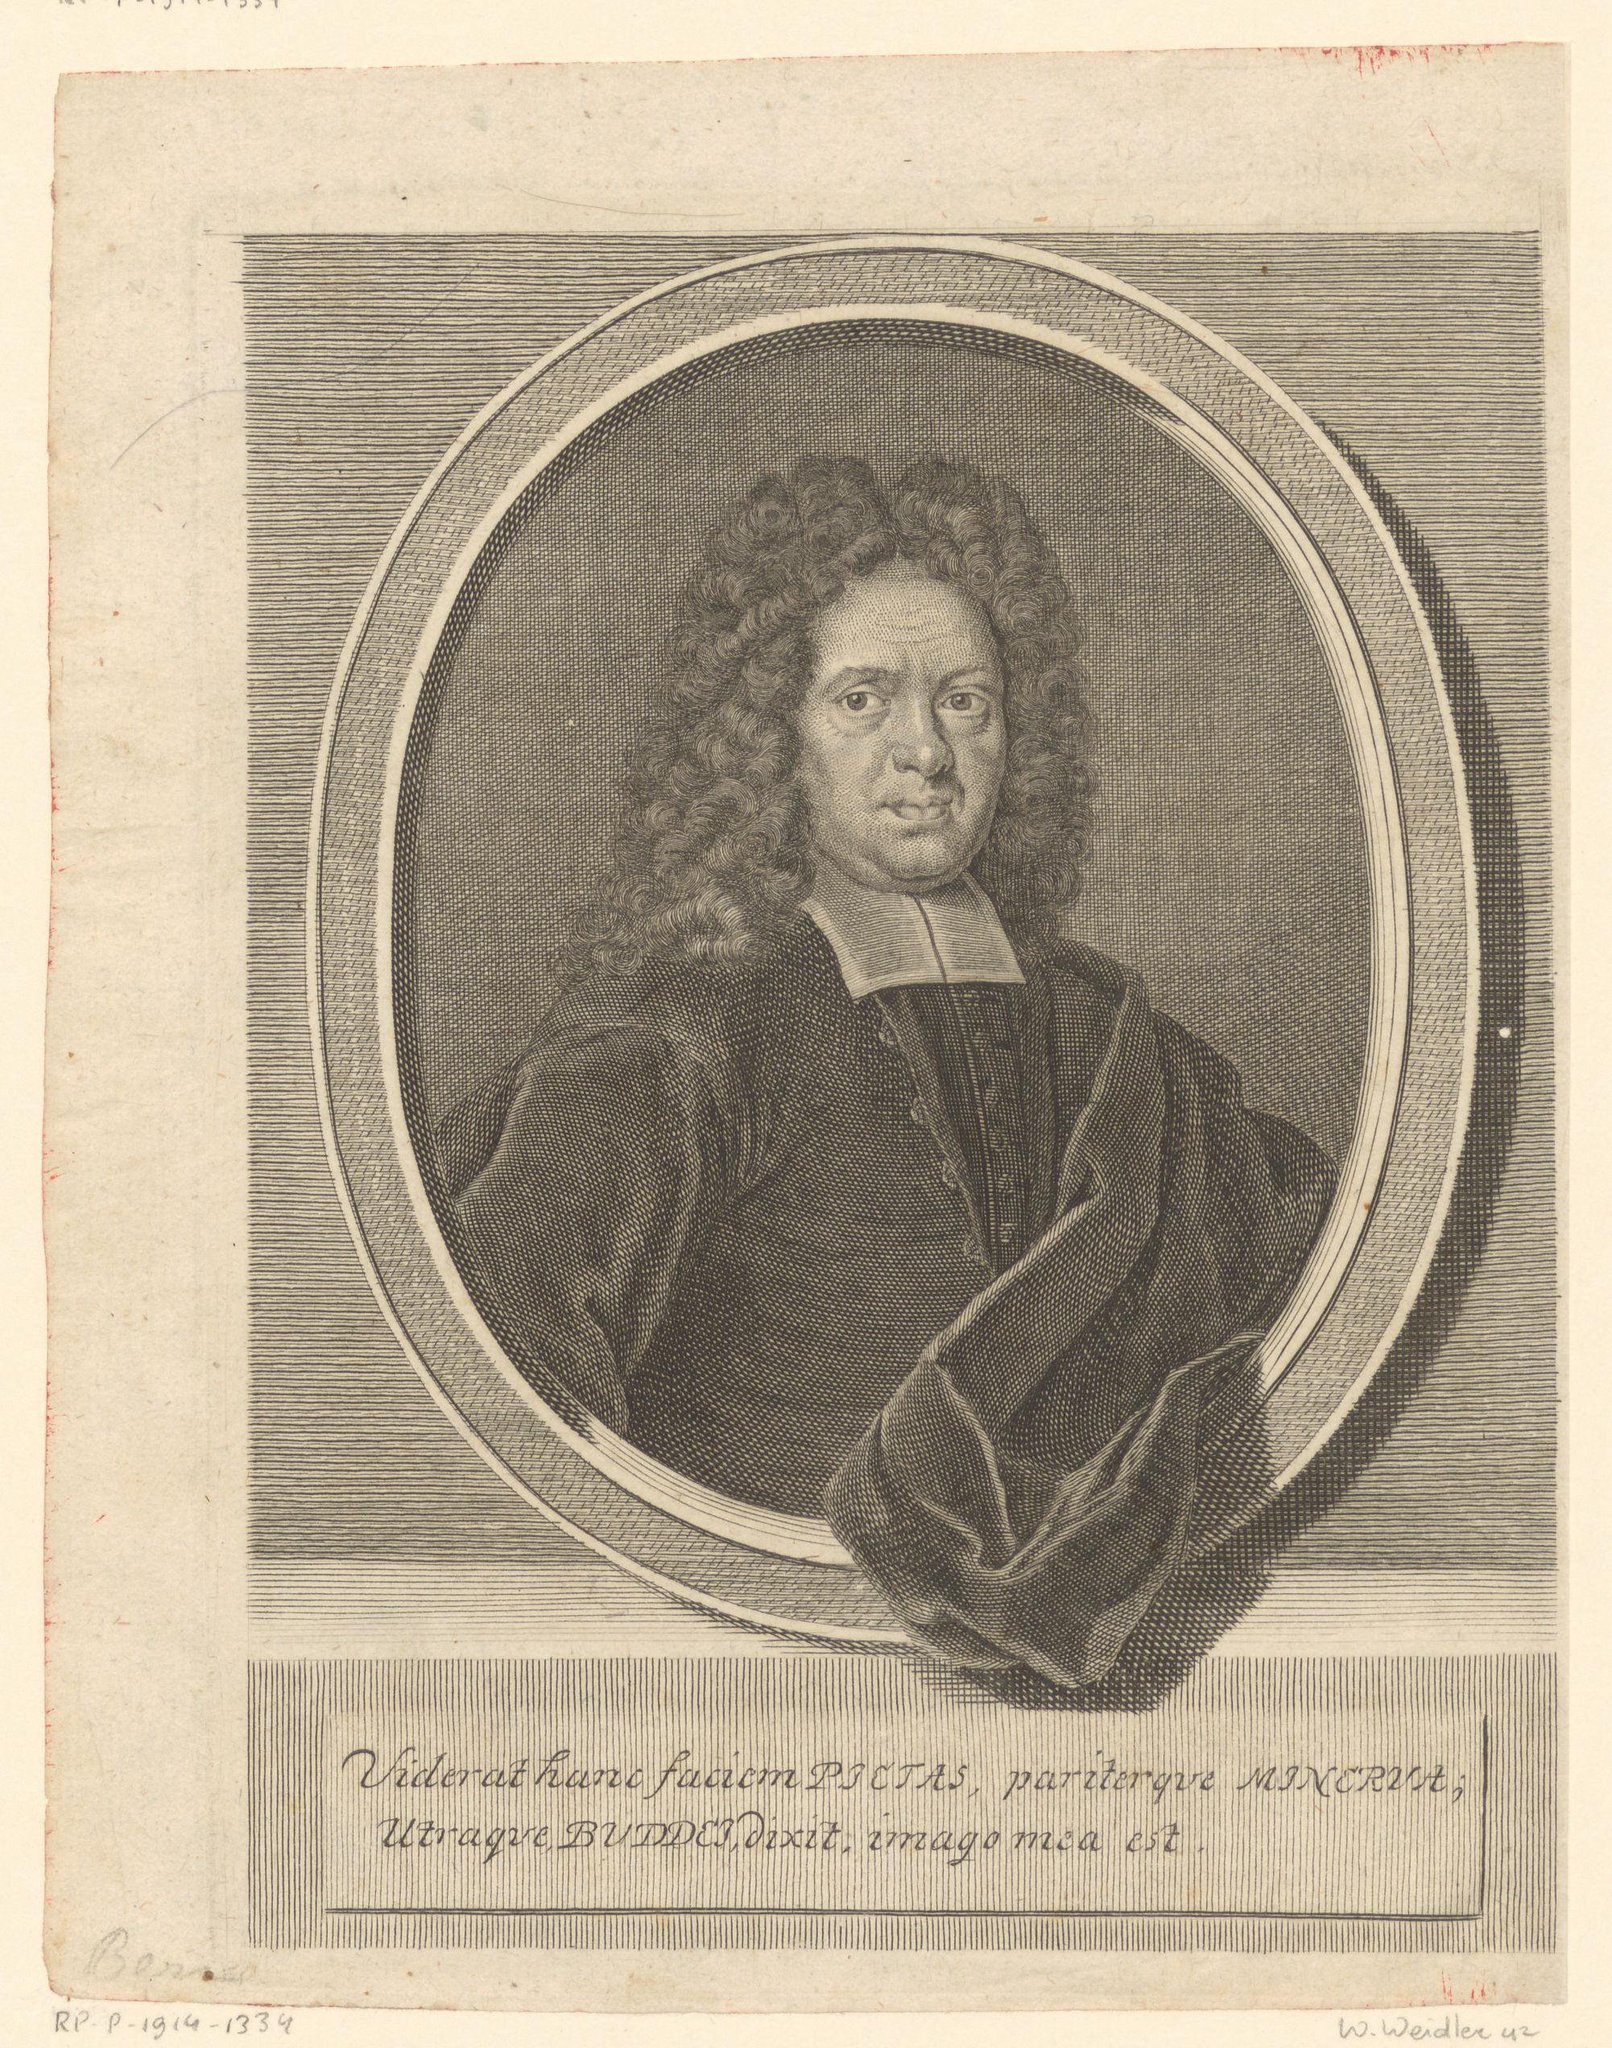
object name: print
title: Portret van Johann Franz Buddeus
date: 1700-1733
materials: paper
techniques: engraving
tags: historical persons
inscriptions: collector's mark: Lugt 2228